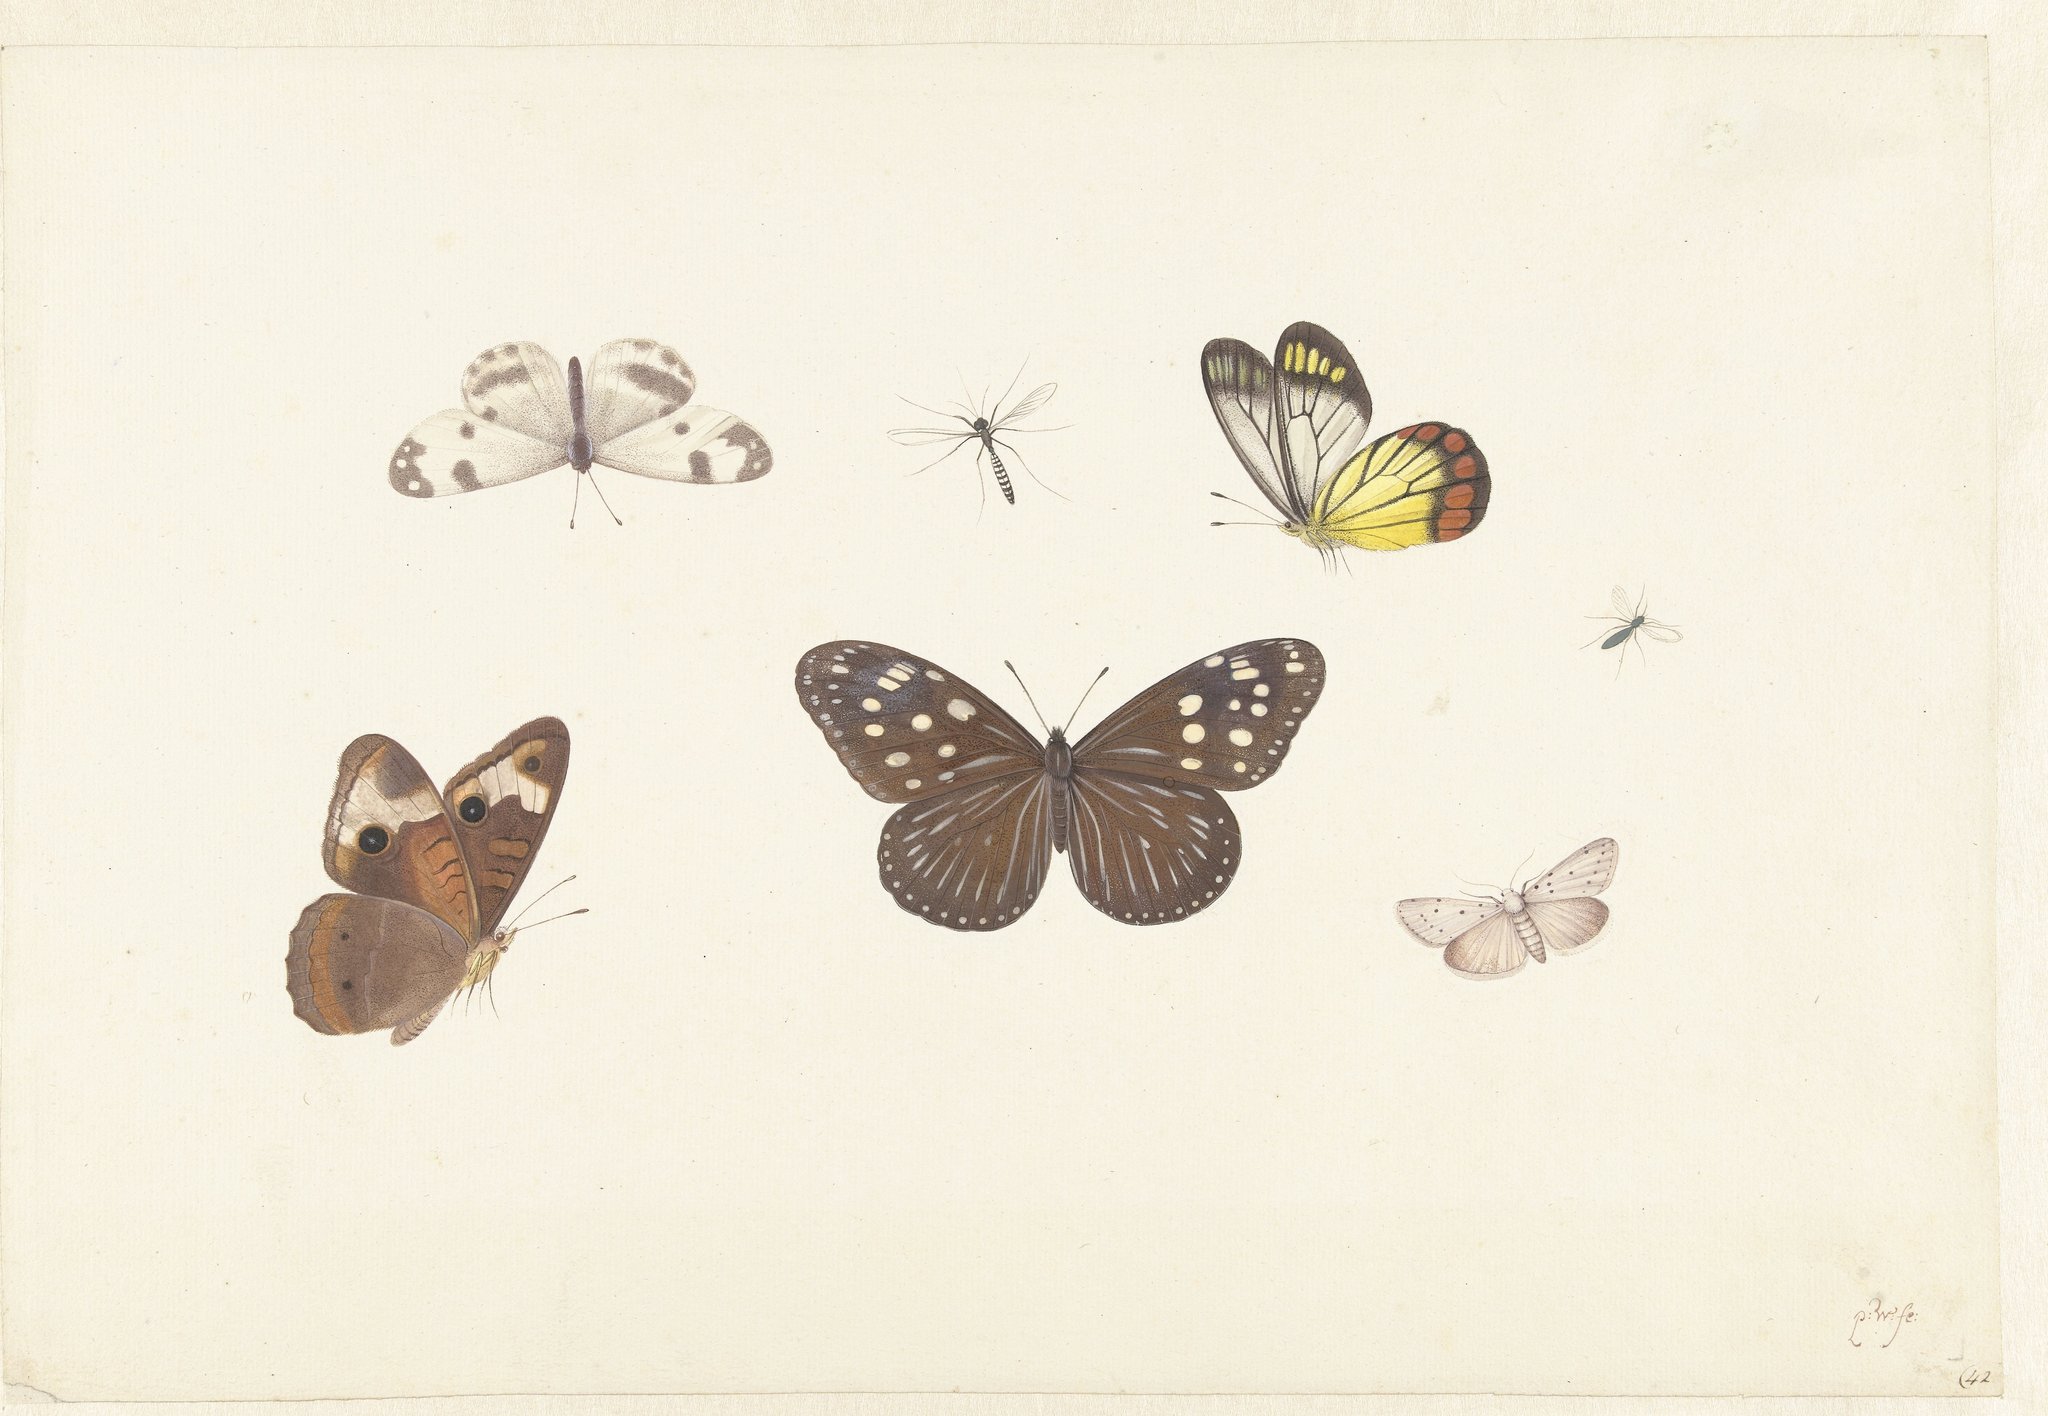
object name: drawing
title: Blad met vijf vlinders en twee vliegen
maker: pieter withoos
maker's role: draughtsman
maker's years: 1654-1693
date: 1674-1692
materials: paper, watercolor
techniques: brush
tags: insects: butterfly, insects: fly